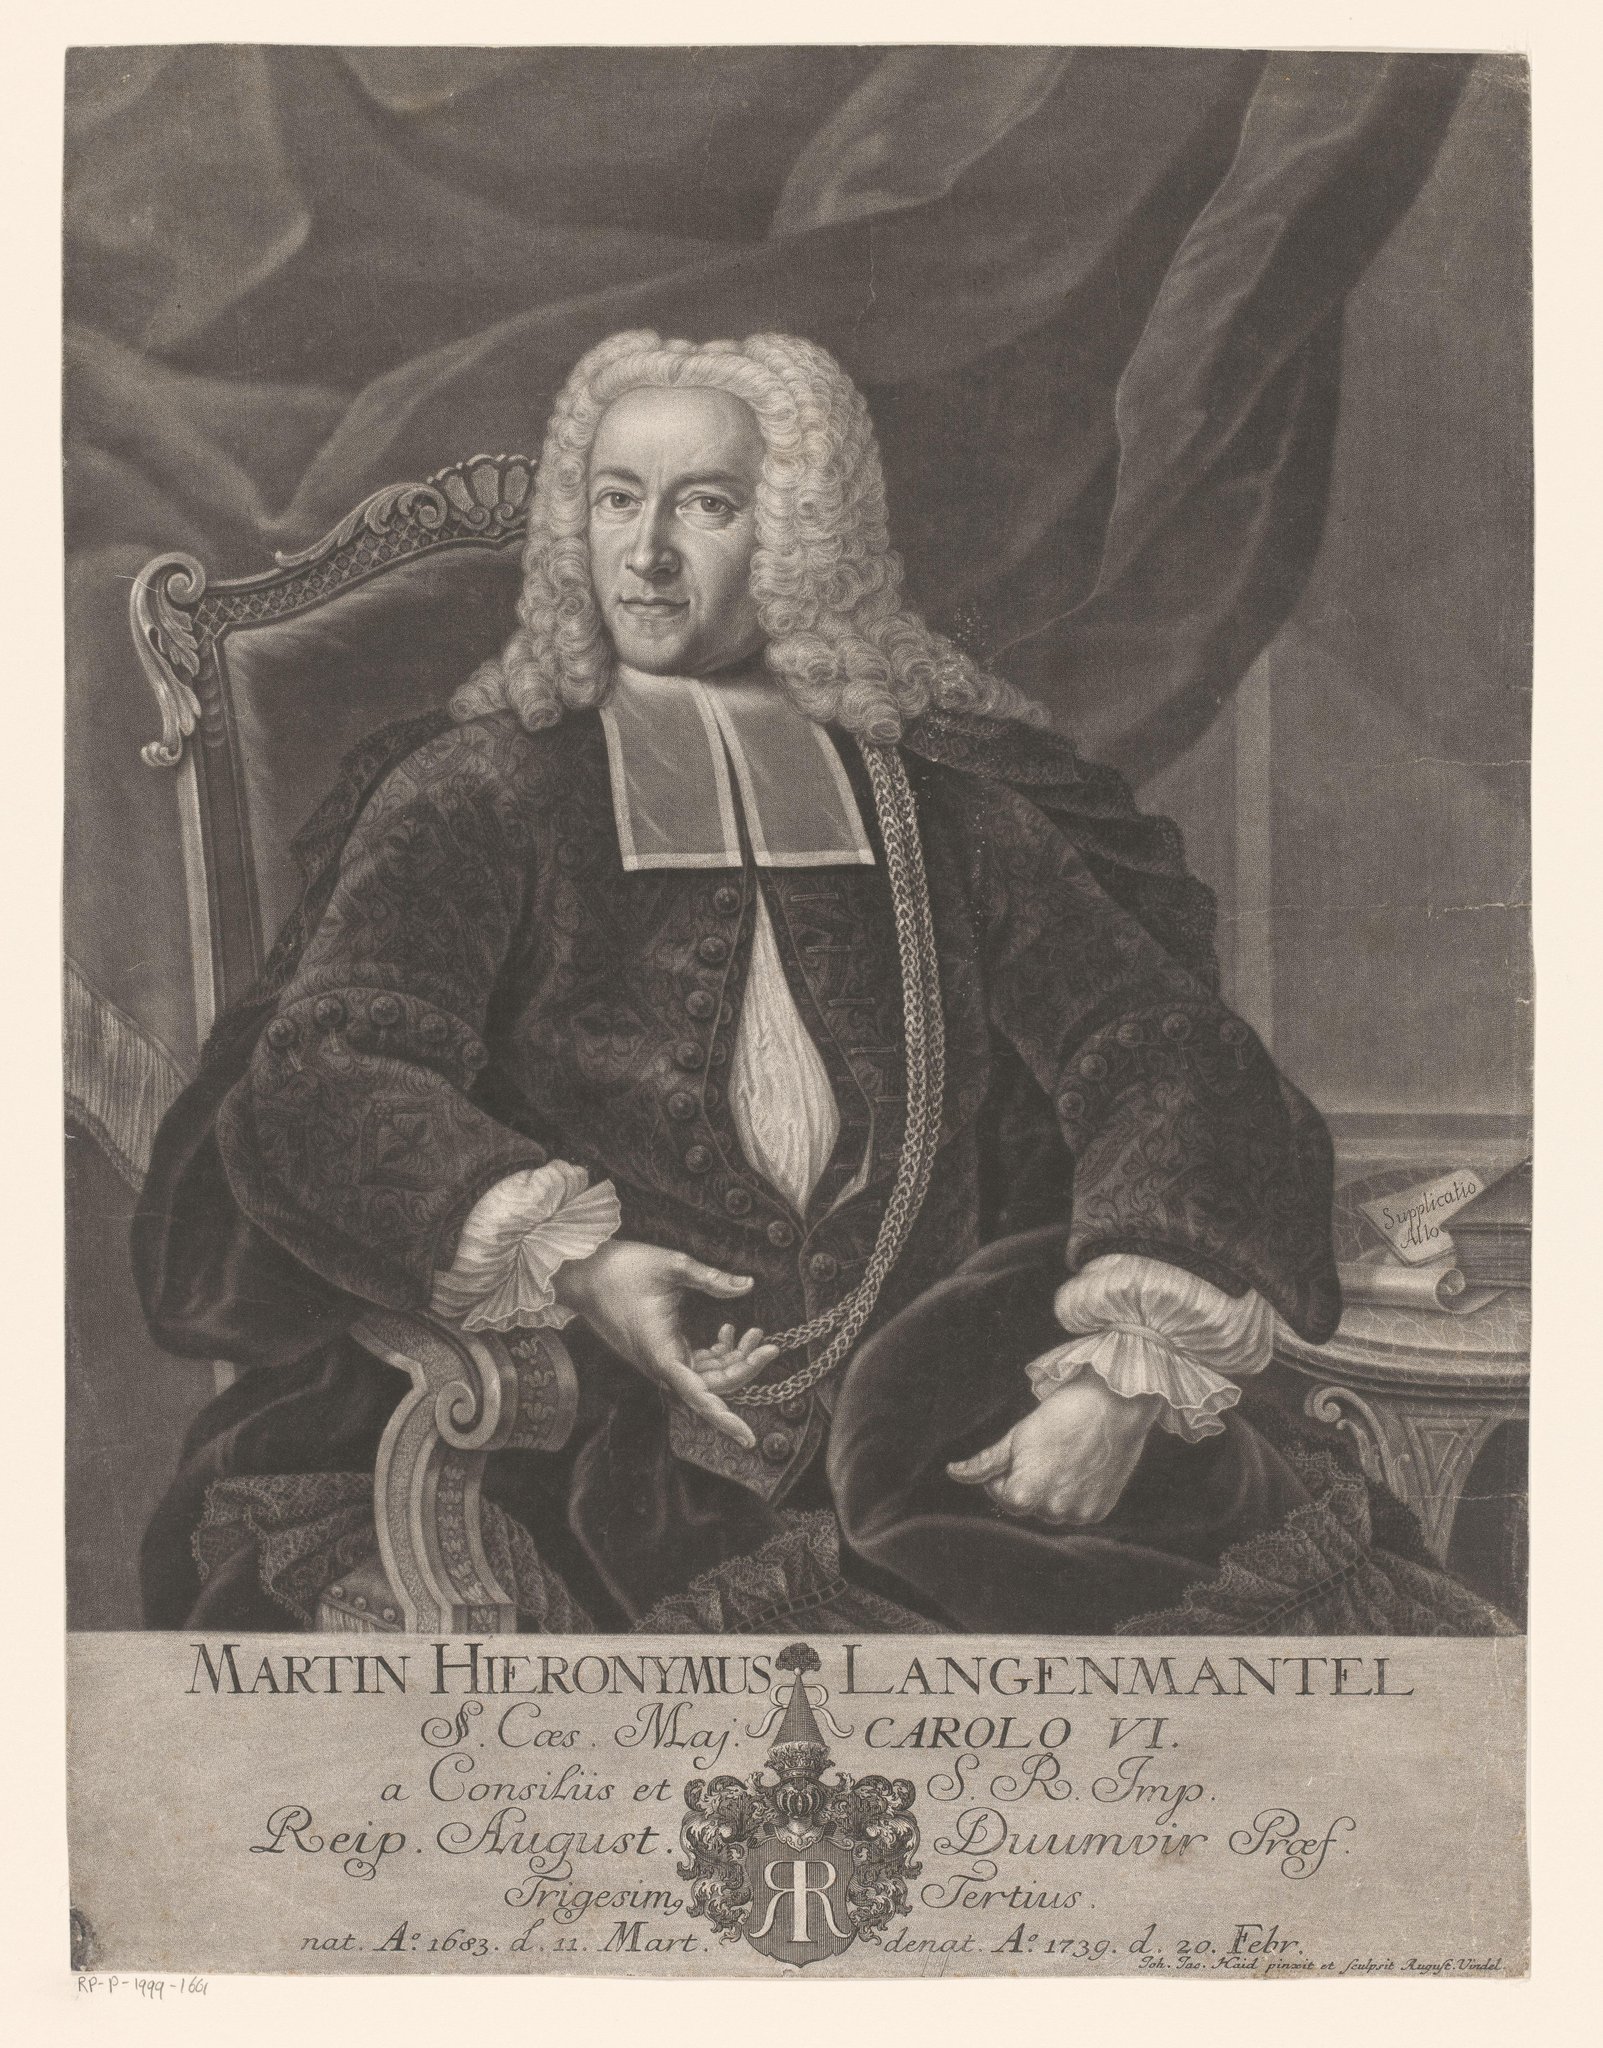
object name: print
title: Portret van Martin Hieronymus von Langenmantel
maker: johann jacob haid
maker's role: print maker, publisher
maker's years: 1704-1767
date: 1739-1767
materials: paper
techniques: etching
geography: augsburg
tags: augsburg, historical persons, book, armorial bearing, heraldry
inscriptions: collector's mark: Lugt 2760, collector's mark: Lugt 2228